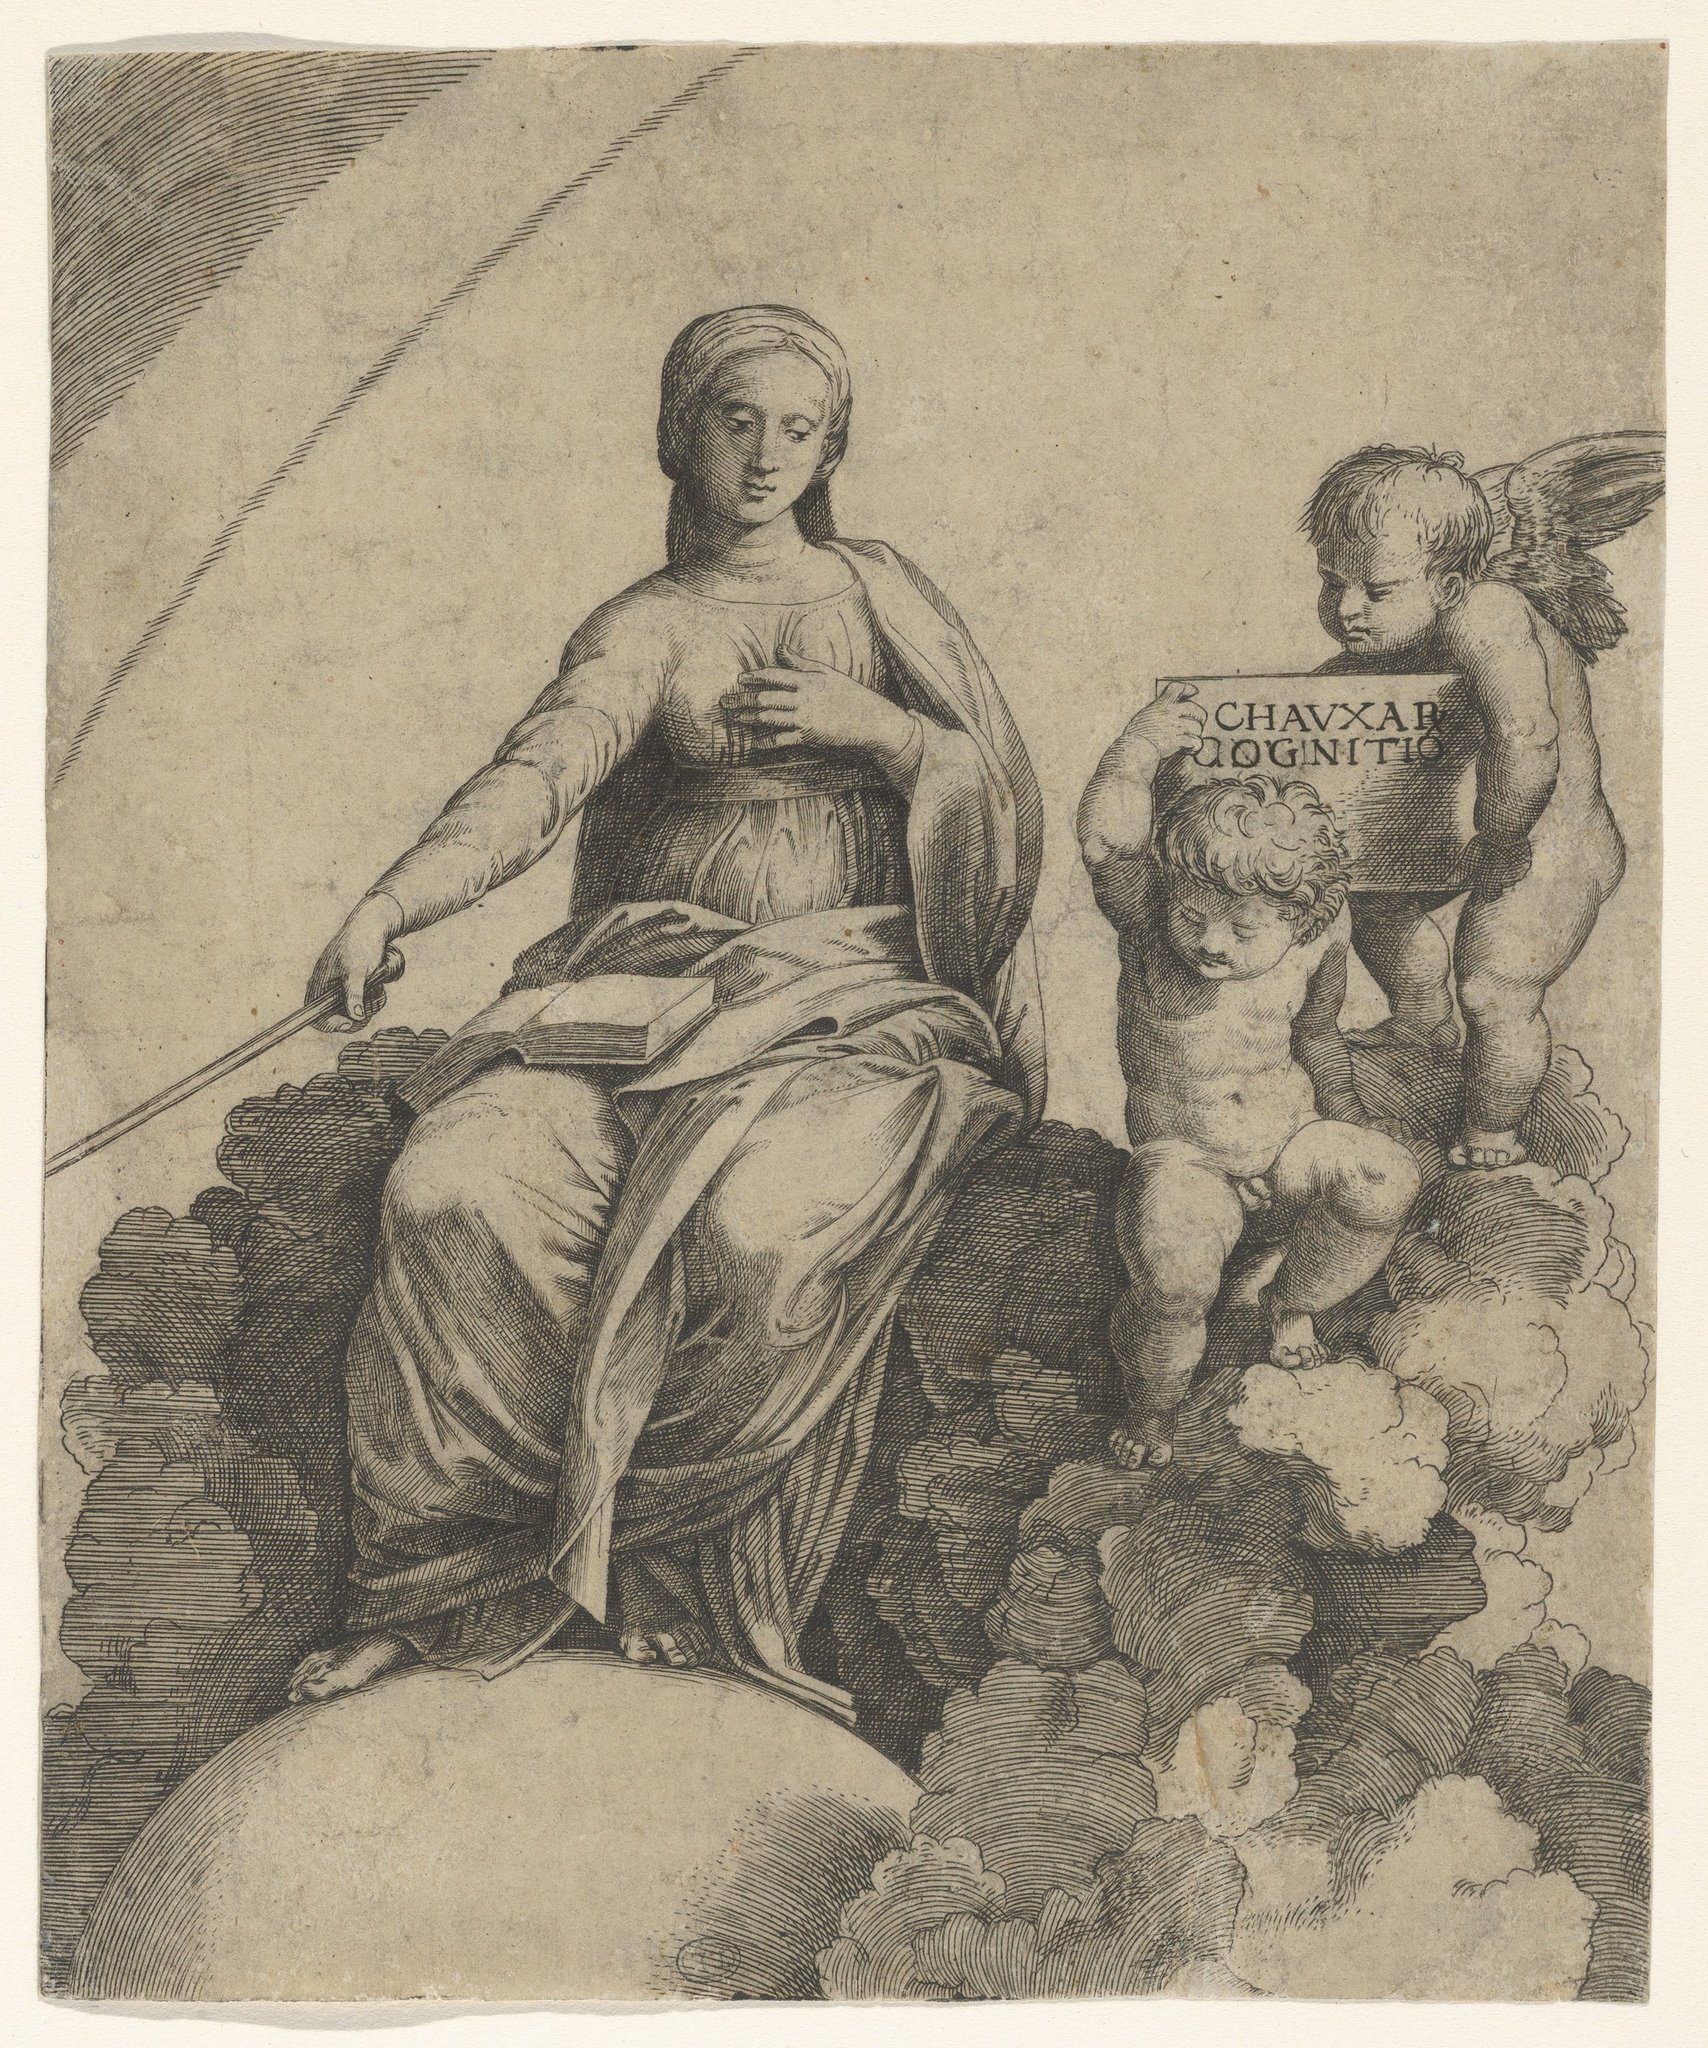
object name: print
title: A personification of Philosophy sitting on clouds with her feet resting on a globe, two putti at right holding a tablet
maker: marcantonio raimondi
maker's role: artist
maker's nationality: italian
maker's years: 1475-1534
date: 1510-1515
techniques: engraving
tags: women,putti